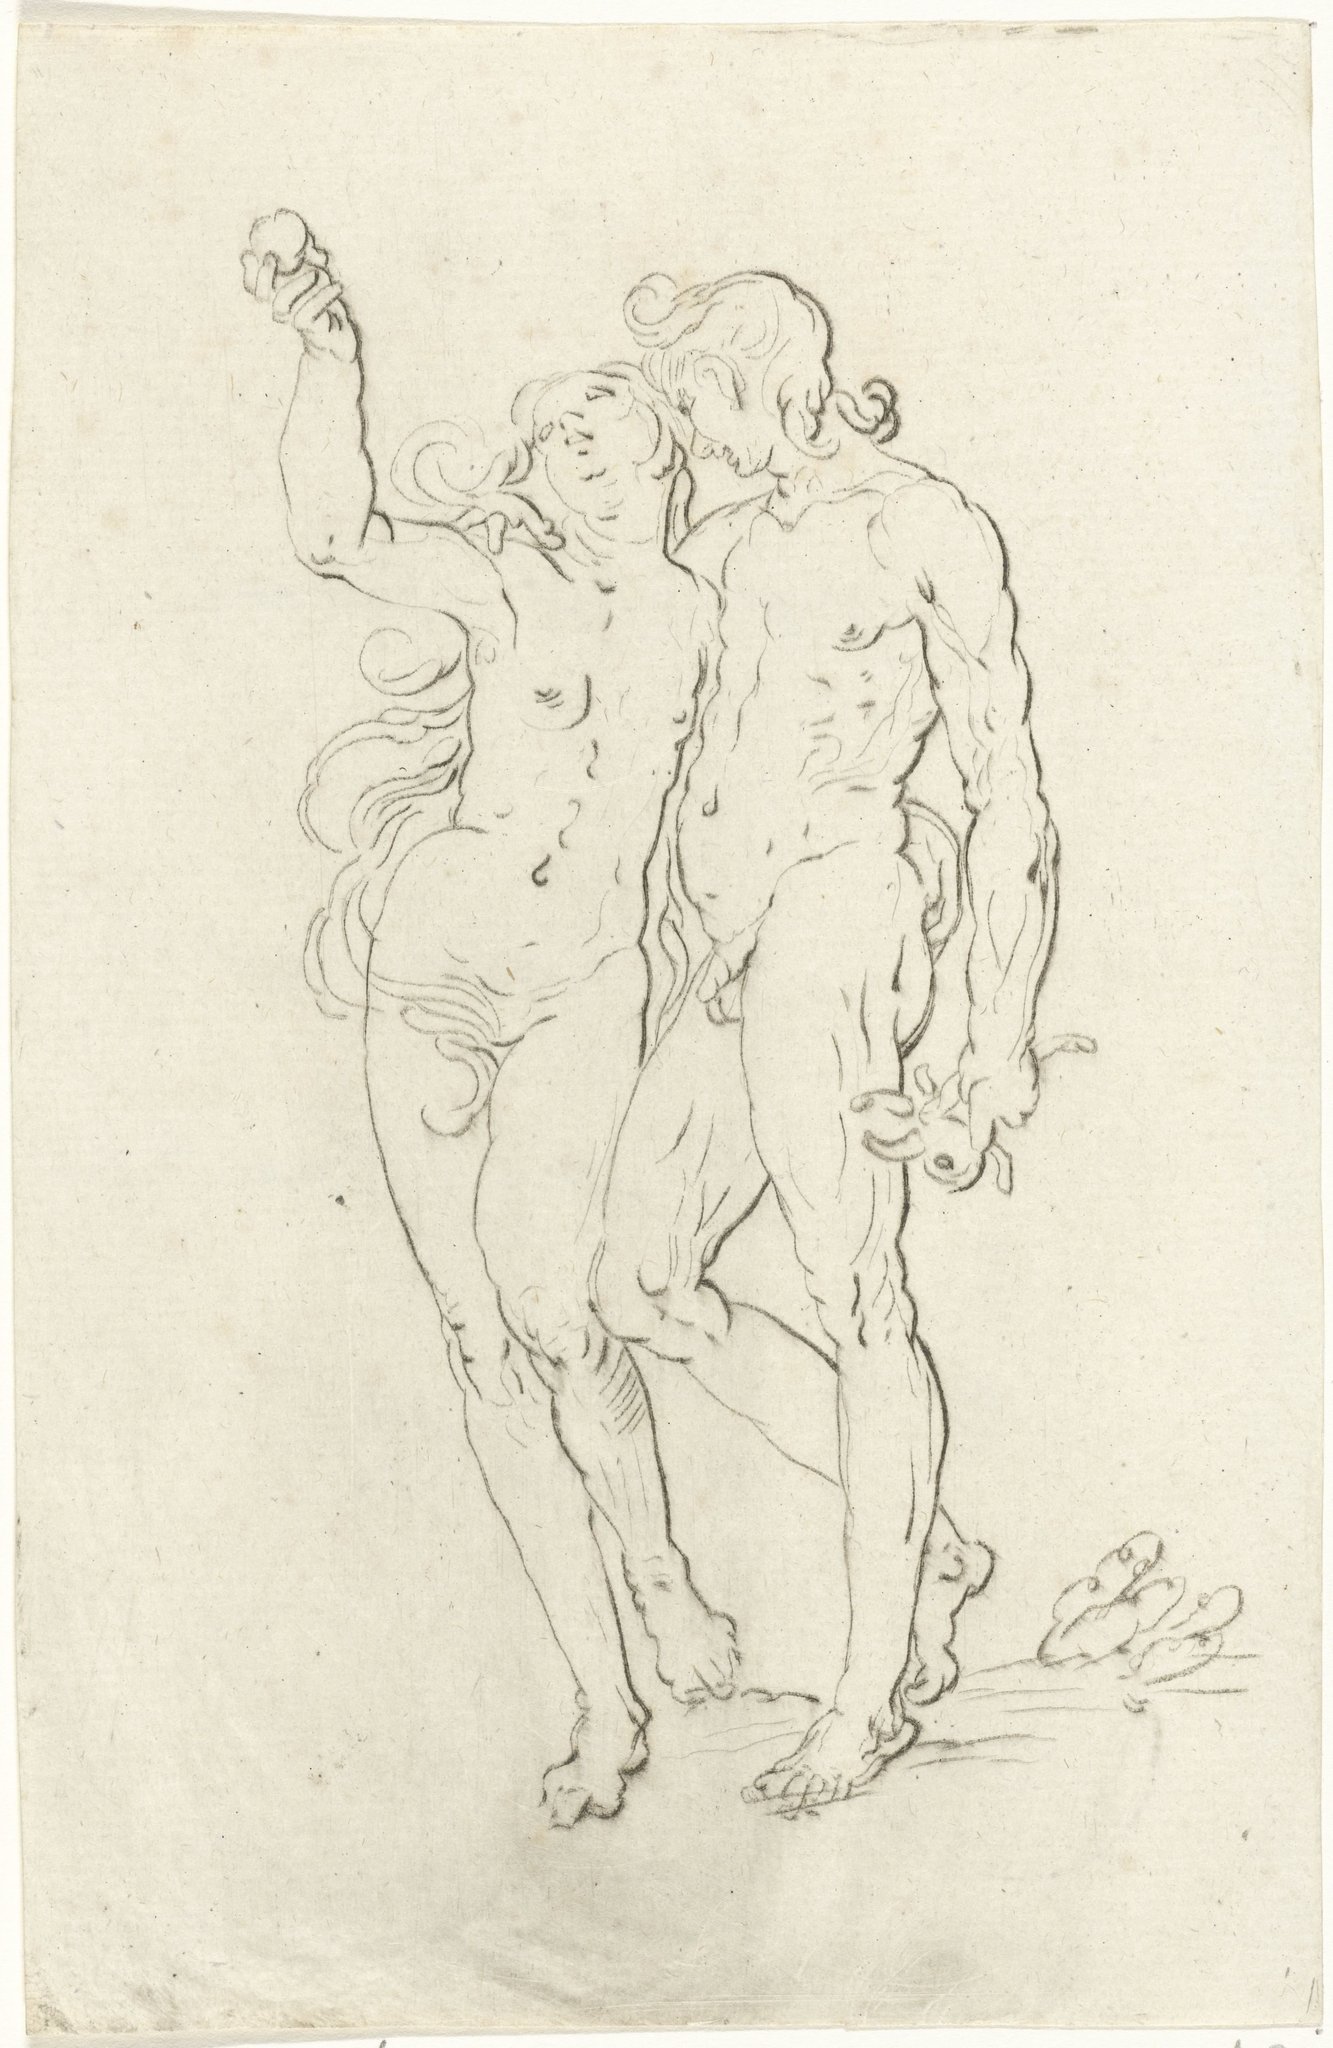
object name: print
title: Adam en Eva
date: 1736-1848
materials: paper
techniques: printmaking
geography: netherlands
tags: adam and eve holding (and possibly eating) the fruit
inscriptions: collector's mark: Lugt 240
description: De naakte Adam en Eva lopen naast elkaar. Eva houdt de appel in haar hand en kijkt ernaar.